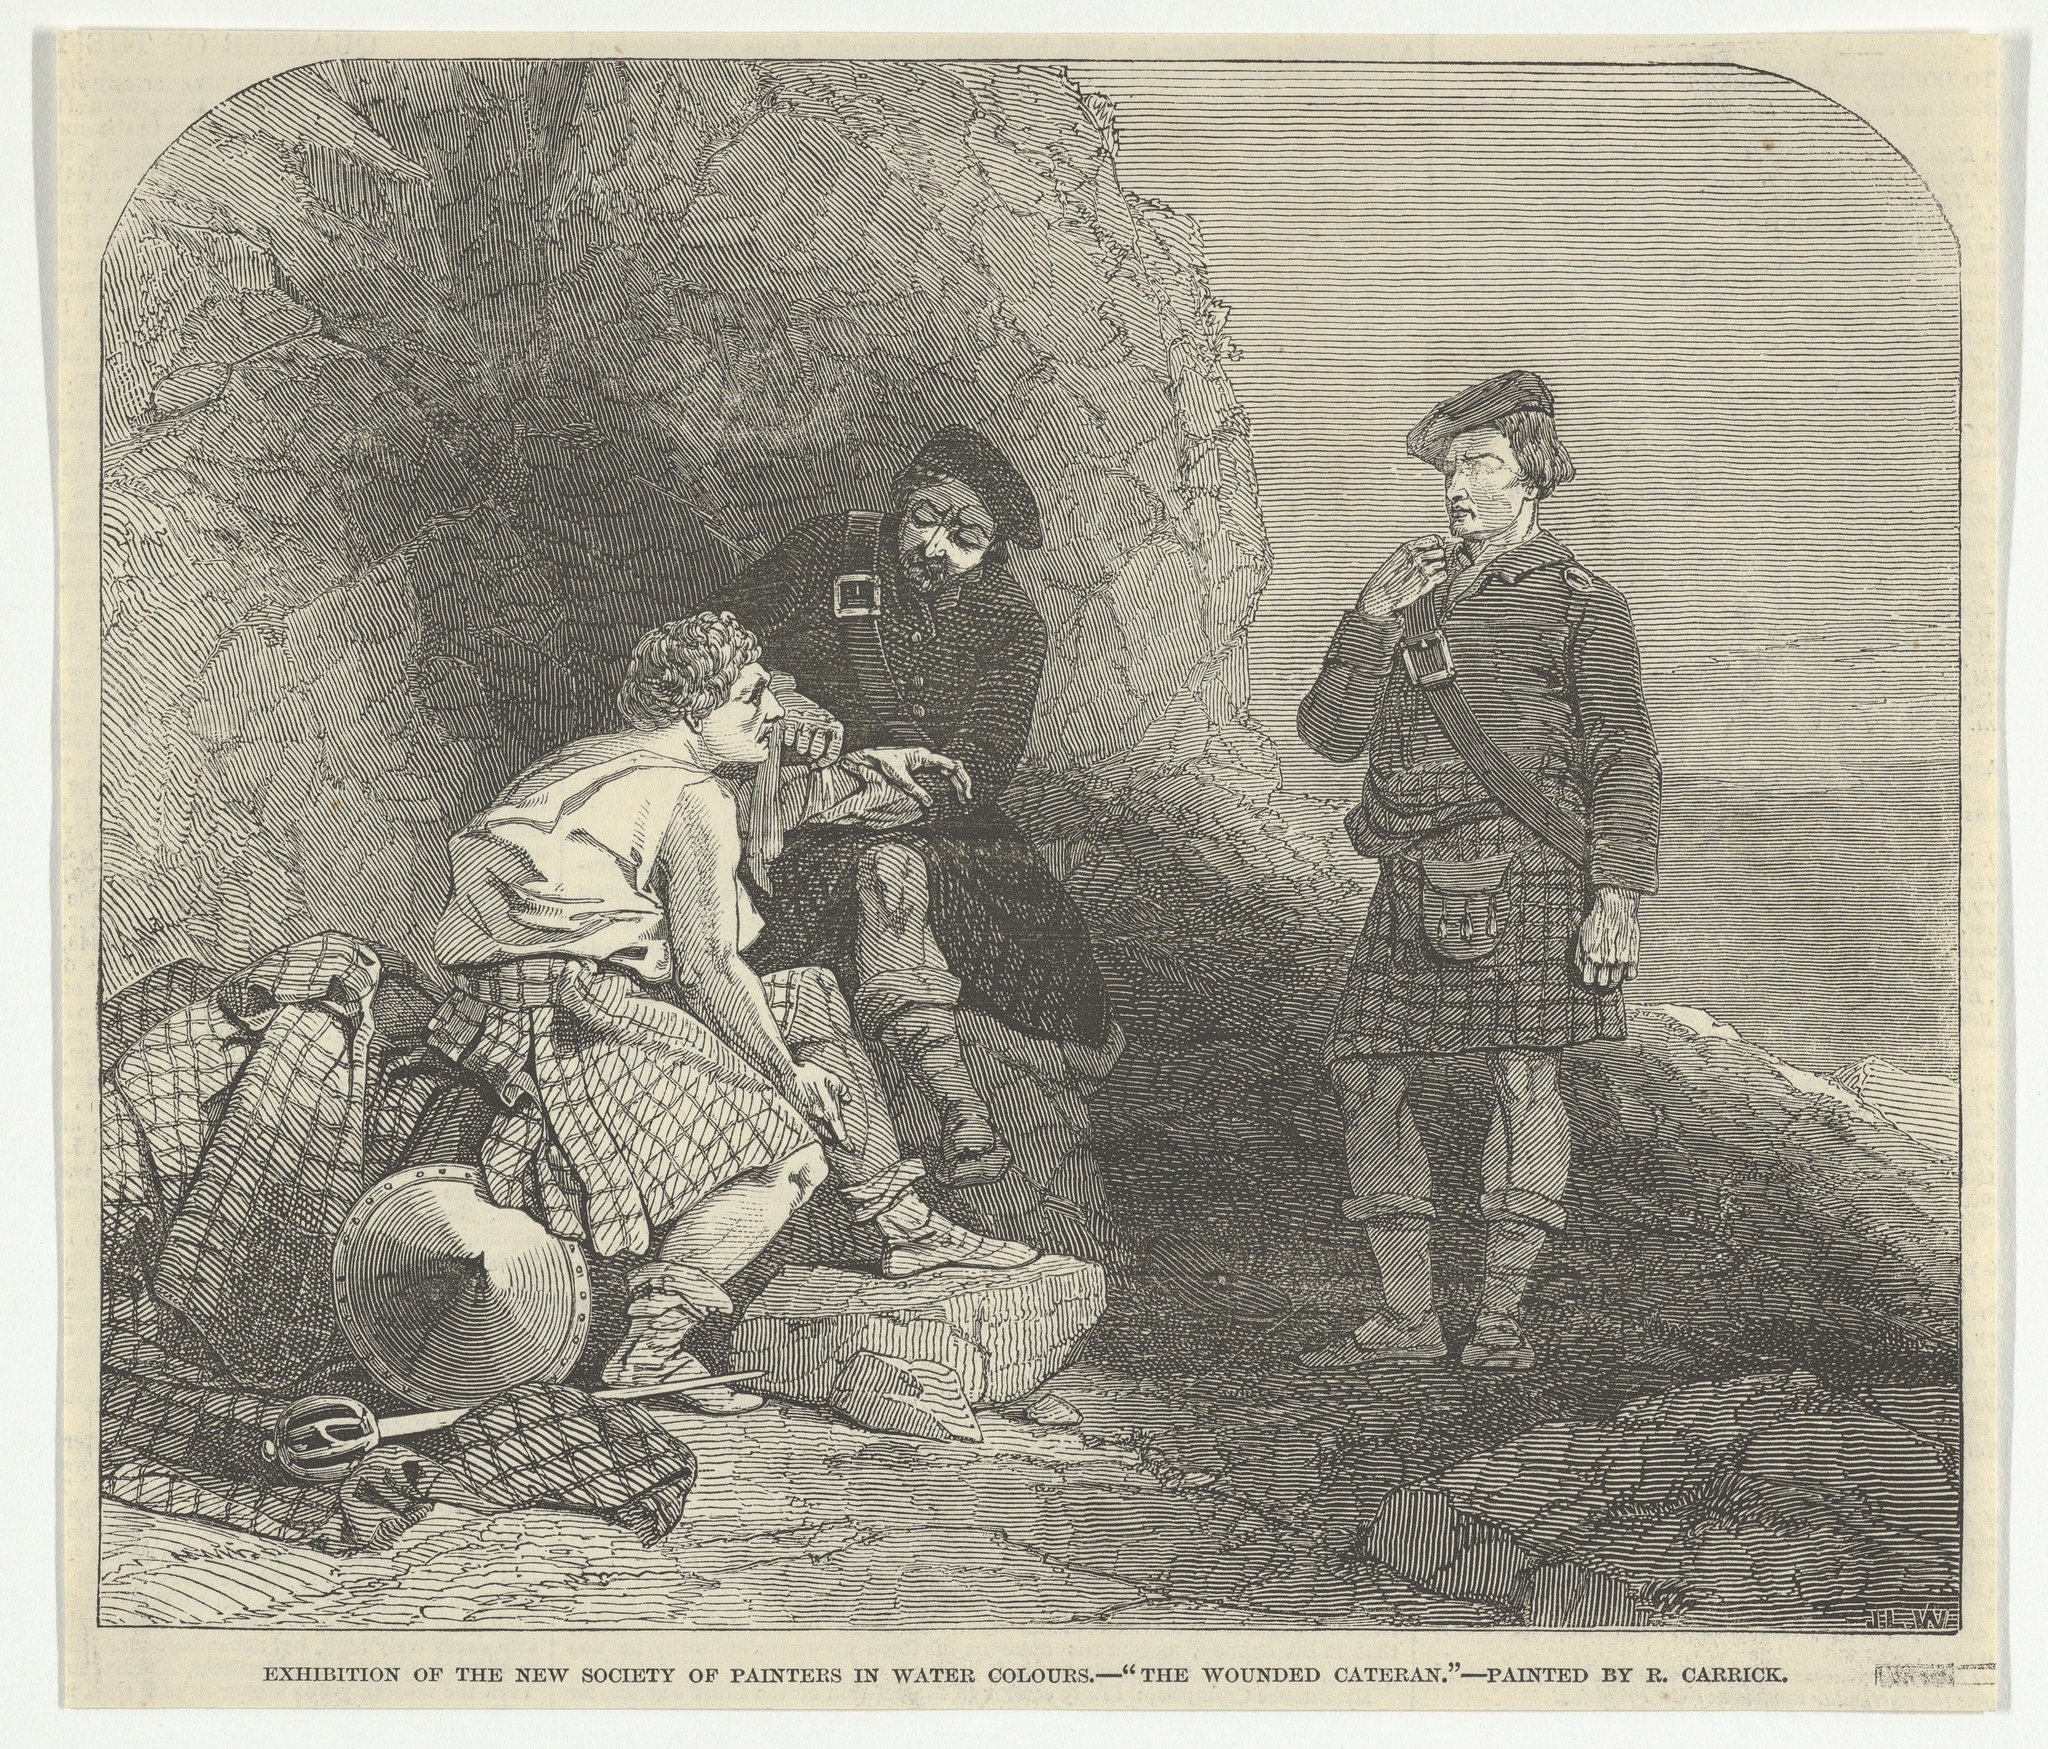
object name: print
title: The Wounded Cateran by R. Carrick, Exhibition of the New Society of Painters in Water Colours, from "Illustrated London News"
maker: joseph lionel williams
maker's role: engraver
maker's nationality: british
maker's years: 1810-1877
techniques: engraving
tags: dresses,men